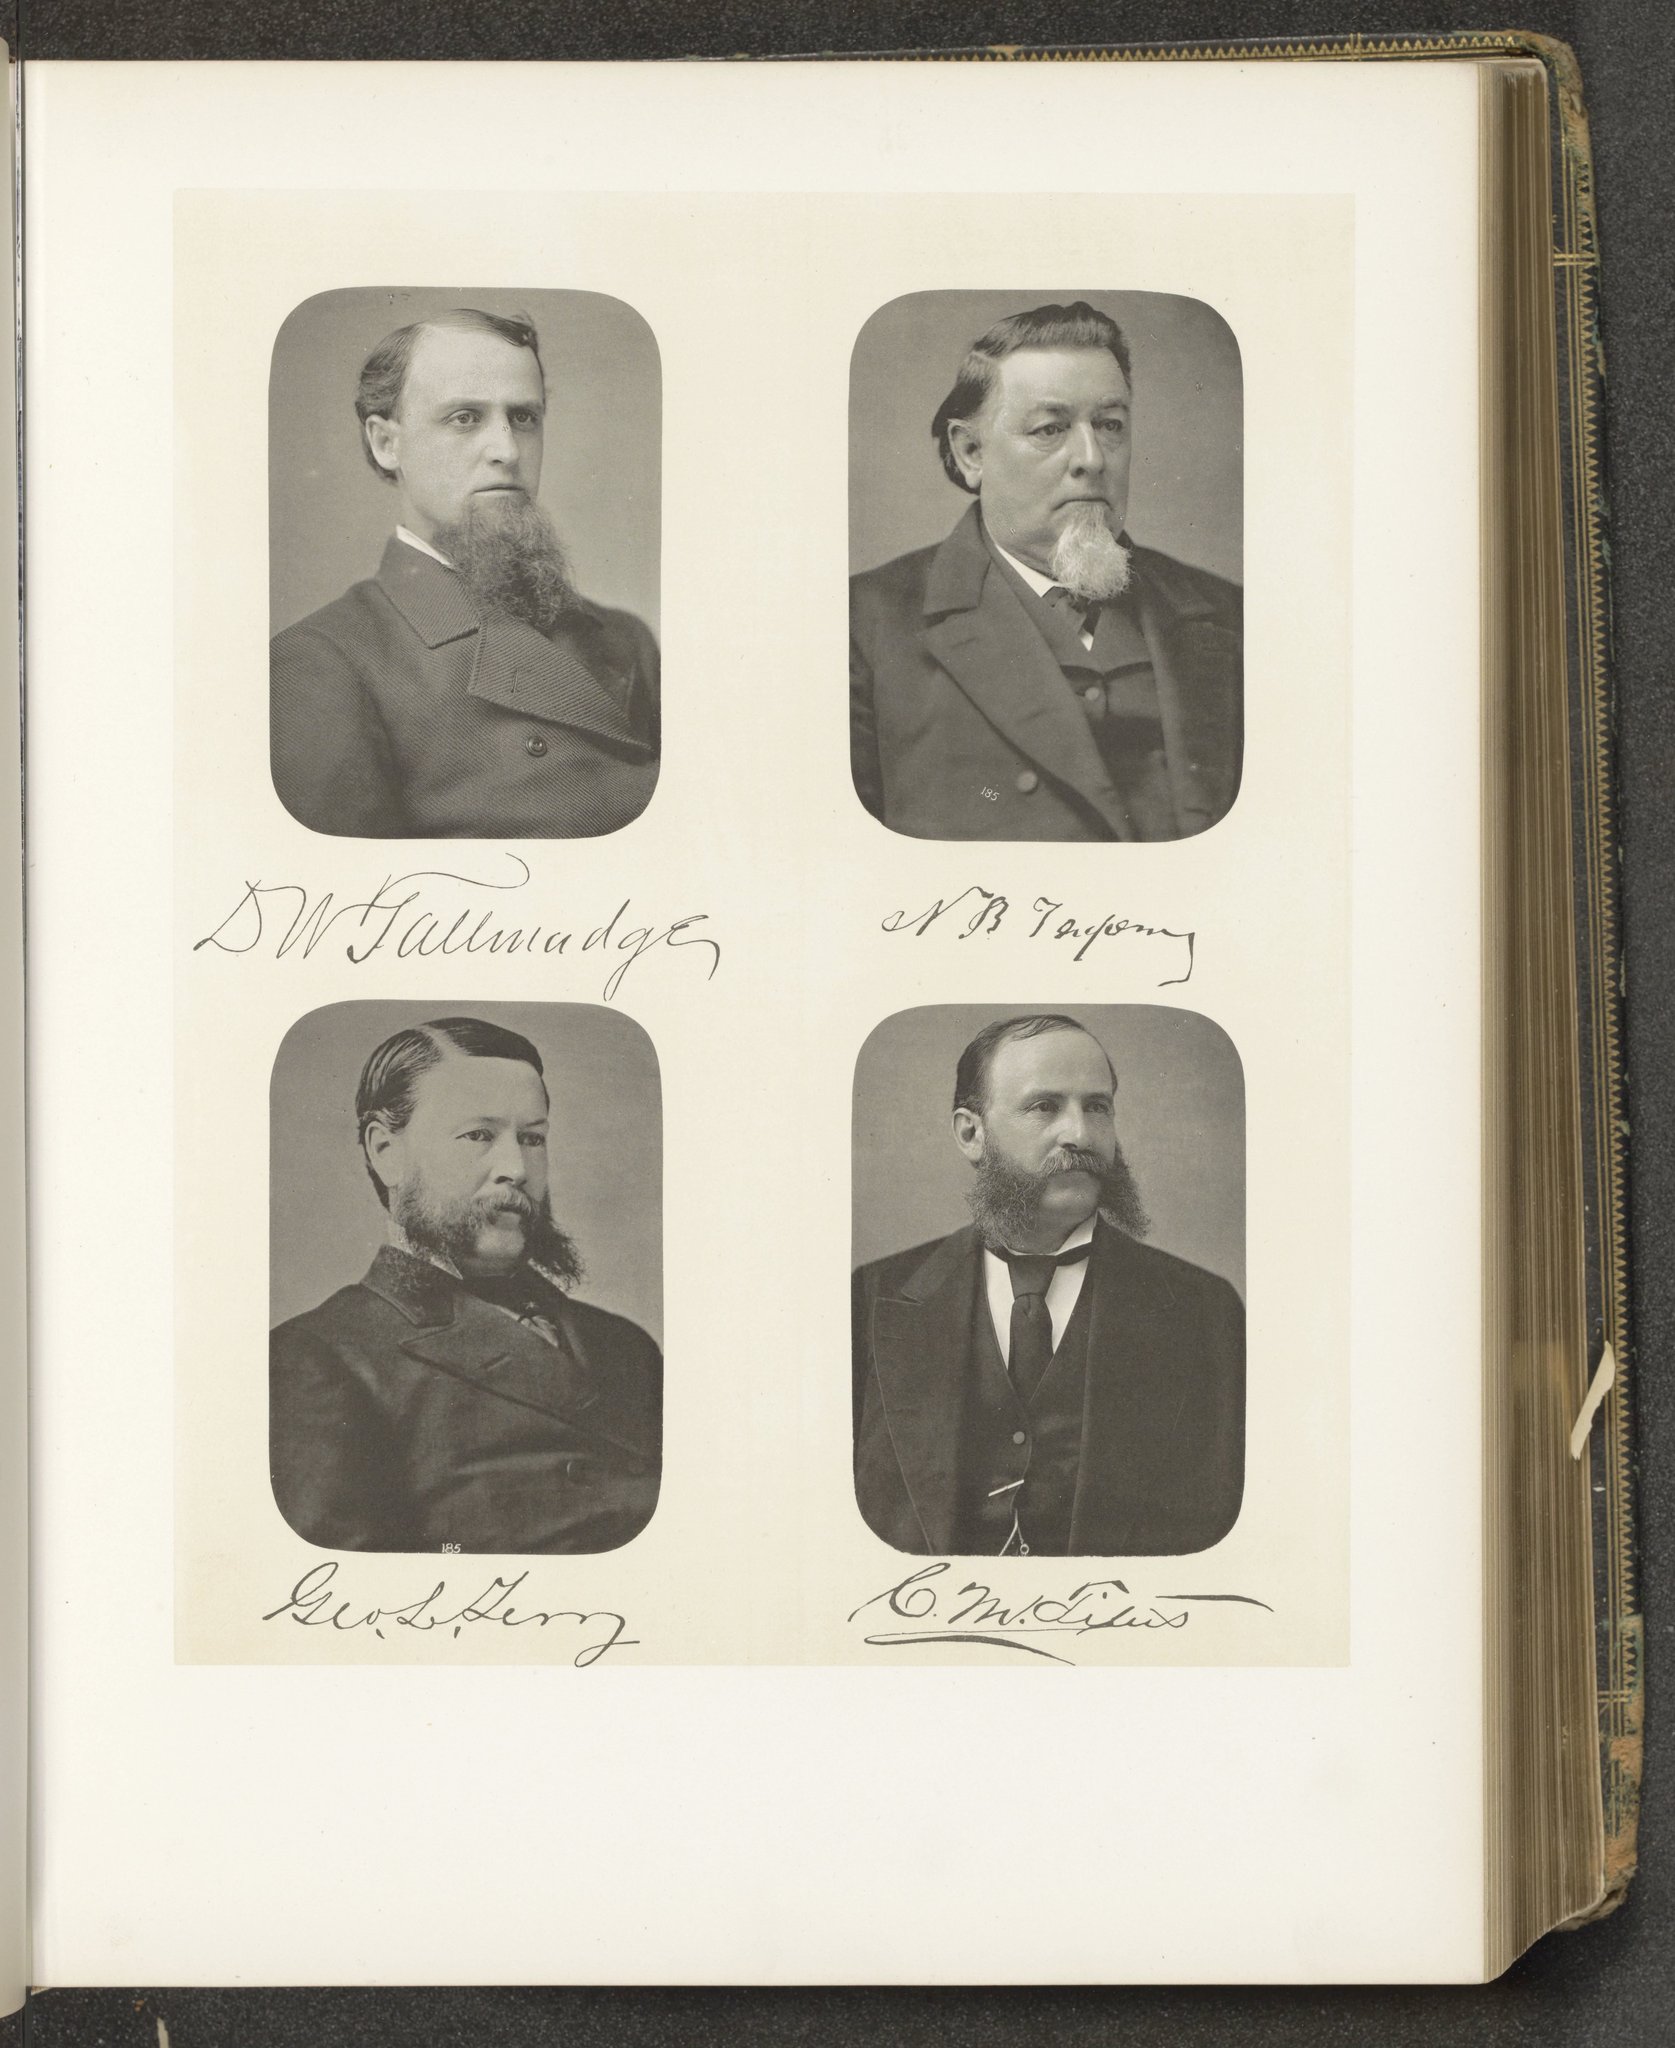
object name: photomechanical print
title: Portretten van vier leden van het Lagerhuis van de staat New York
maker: Anonymous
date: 1872-1882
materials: paper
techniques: photograph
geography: united states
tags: historical persons (portraits and scenes from the life) (+ head (and shoulders) (portrait))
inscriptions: annotation, number: ‘185’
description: Linksboven D.W. Tallmadge, rechtsboven Nathaniel B. Terpeny, linksonder George L. Terry, rechtsonder Charles M. Titus.